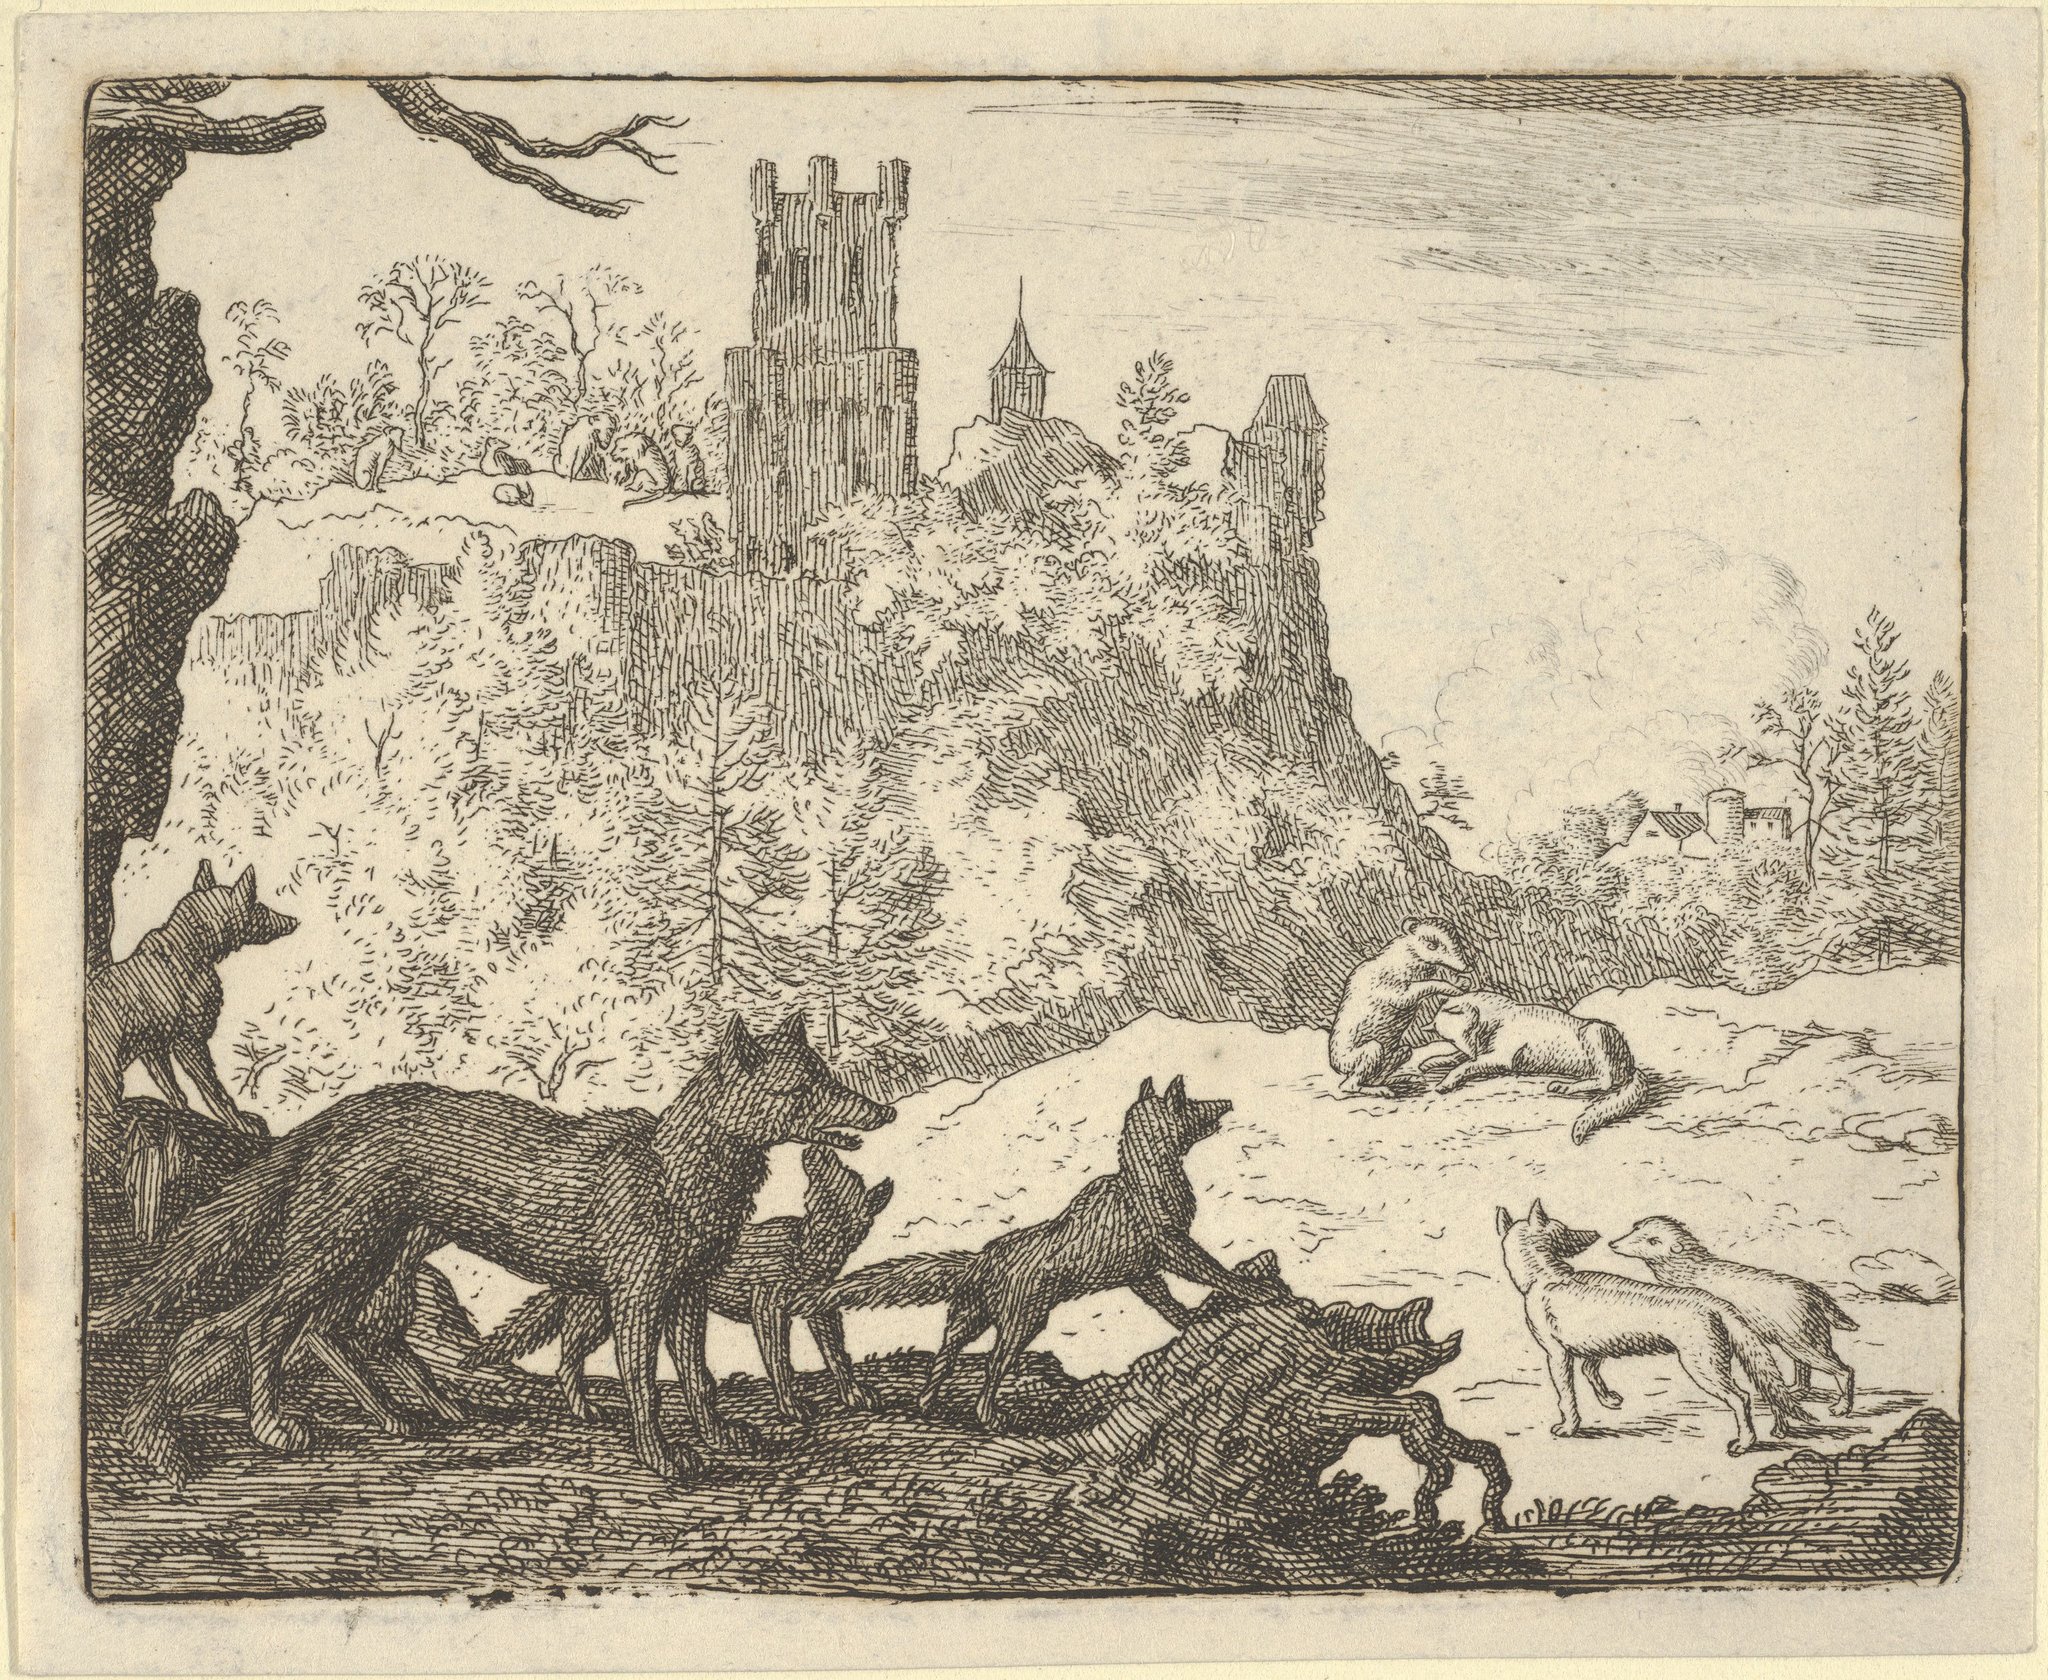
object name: print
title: Renard Leaves with the badger from Hendrick van Alcmar's Renard The Fox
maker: allart van everdingen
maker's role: artist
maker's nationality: dutch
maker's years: 1621-1675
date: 1650-1675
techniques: engraving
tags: foxes,landscapes,trees